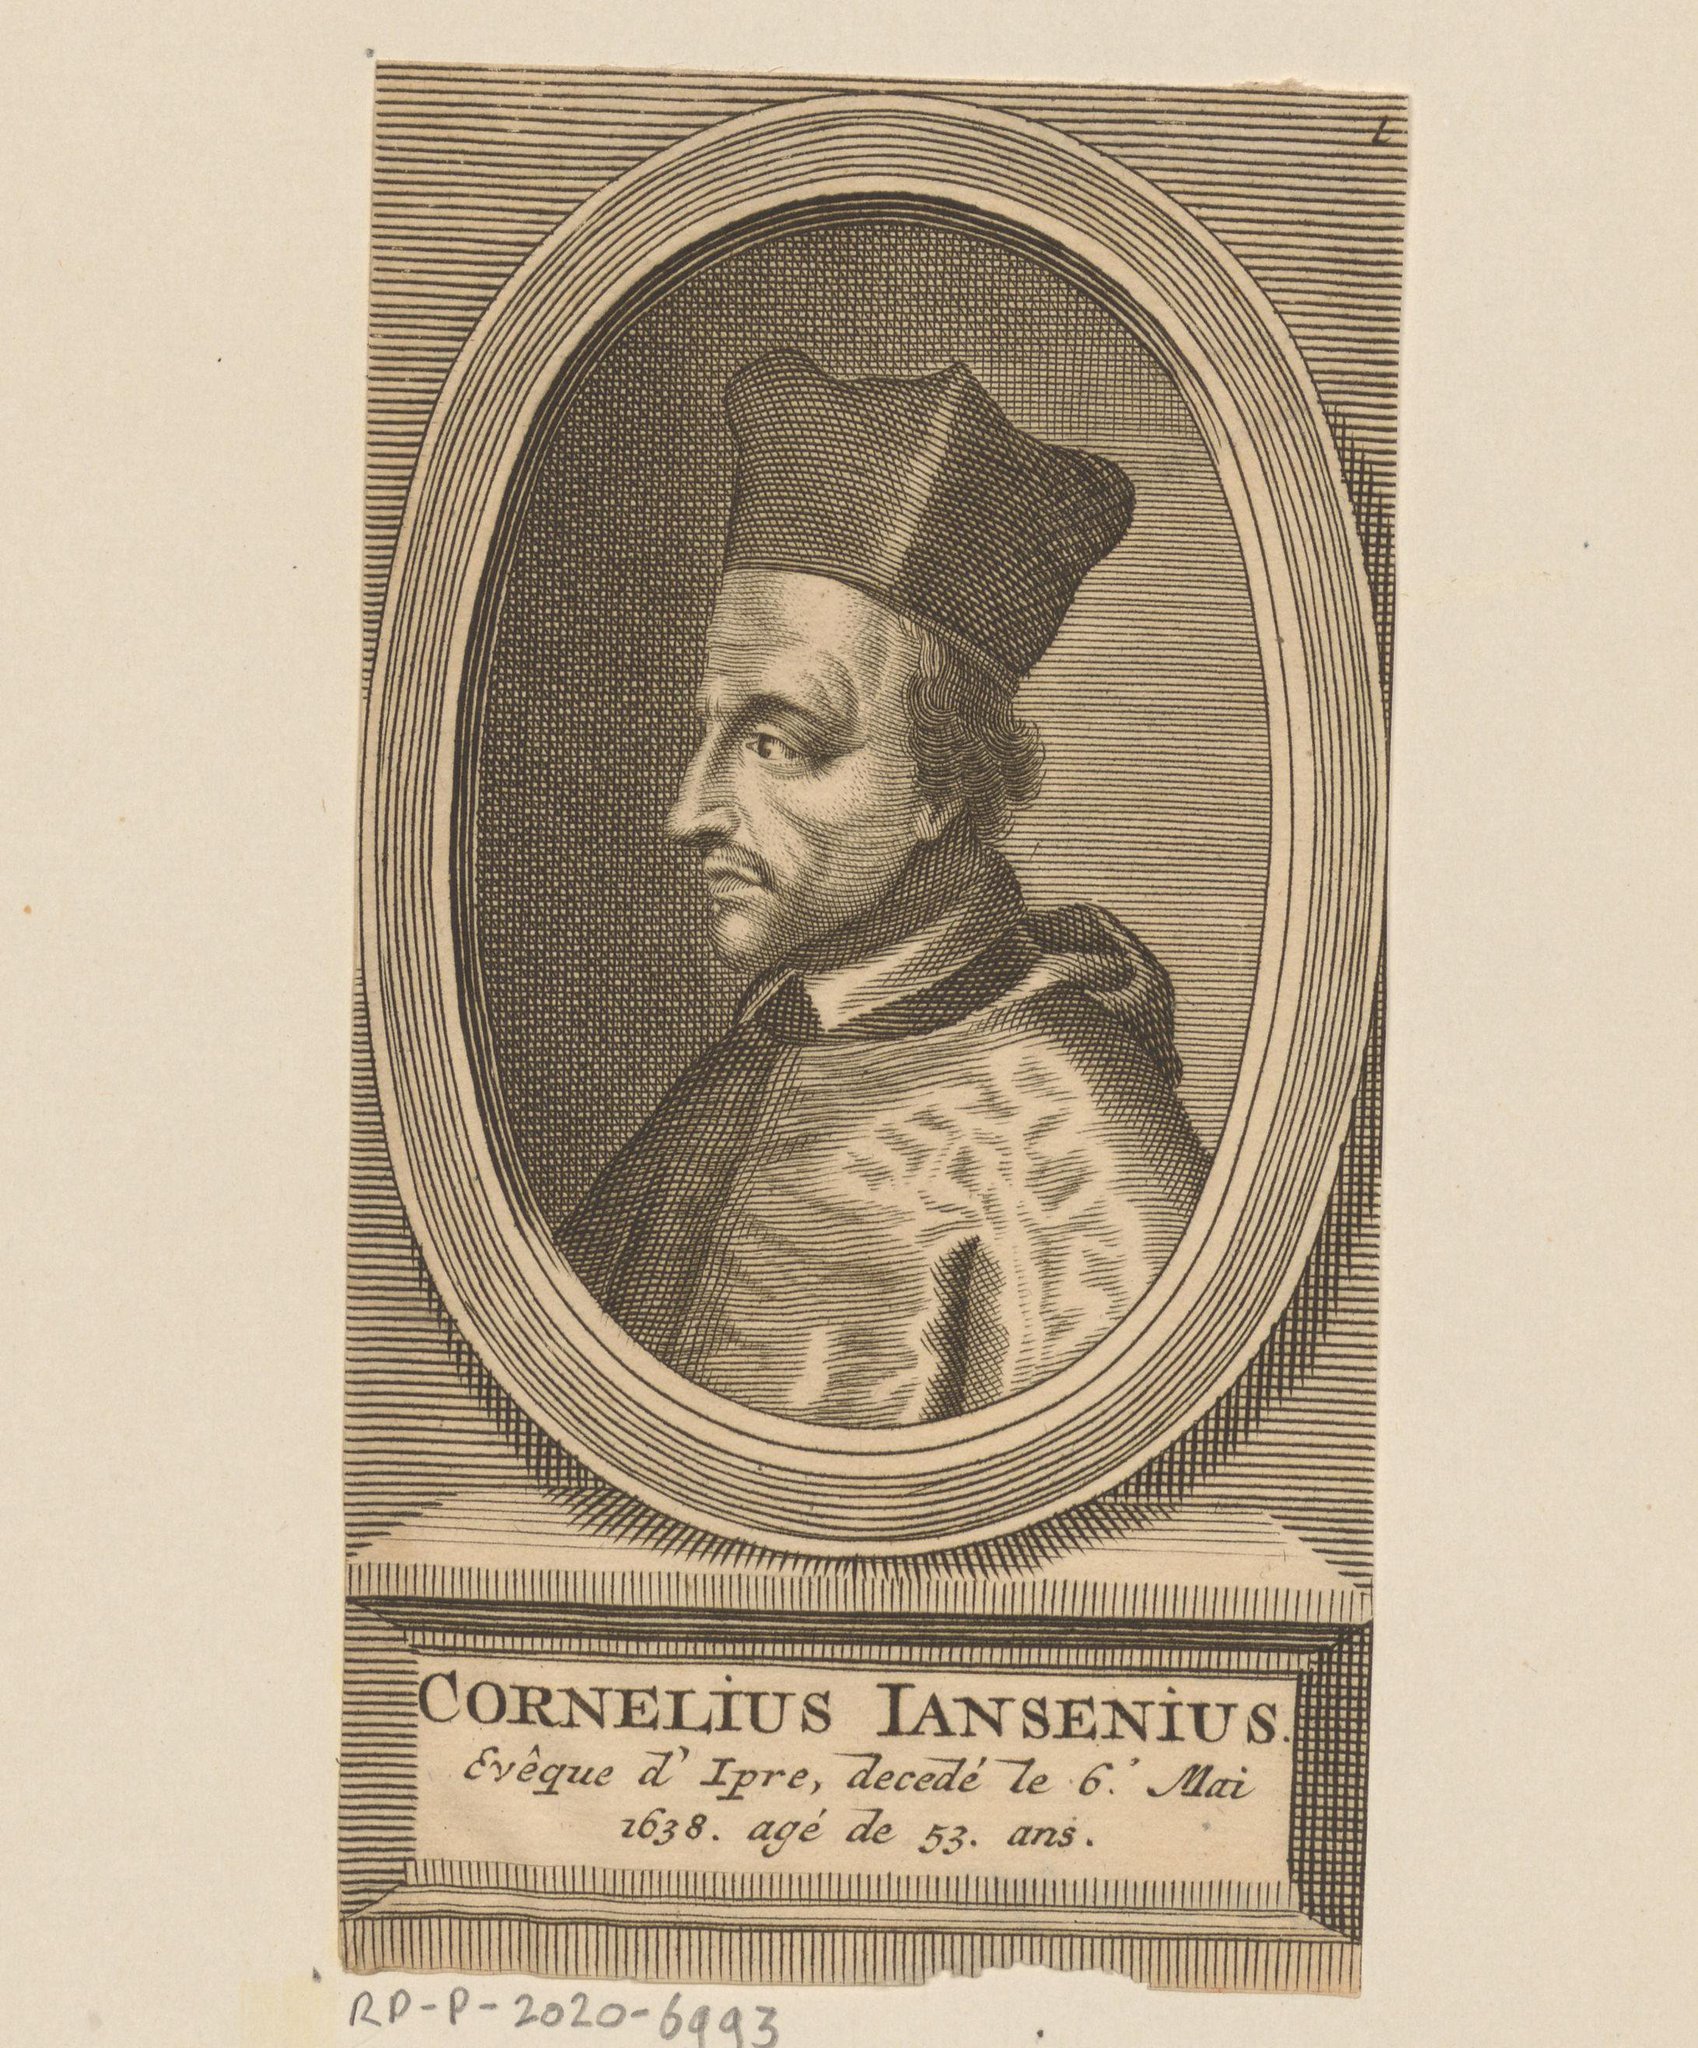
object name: print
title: Portret van Cornelius Jansenius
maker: Anonymous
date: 1638-1699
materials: paper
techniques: engraving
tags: priest, archbishop, bishop, etc. (roman catholic), theologian, historical persons